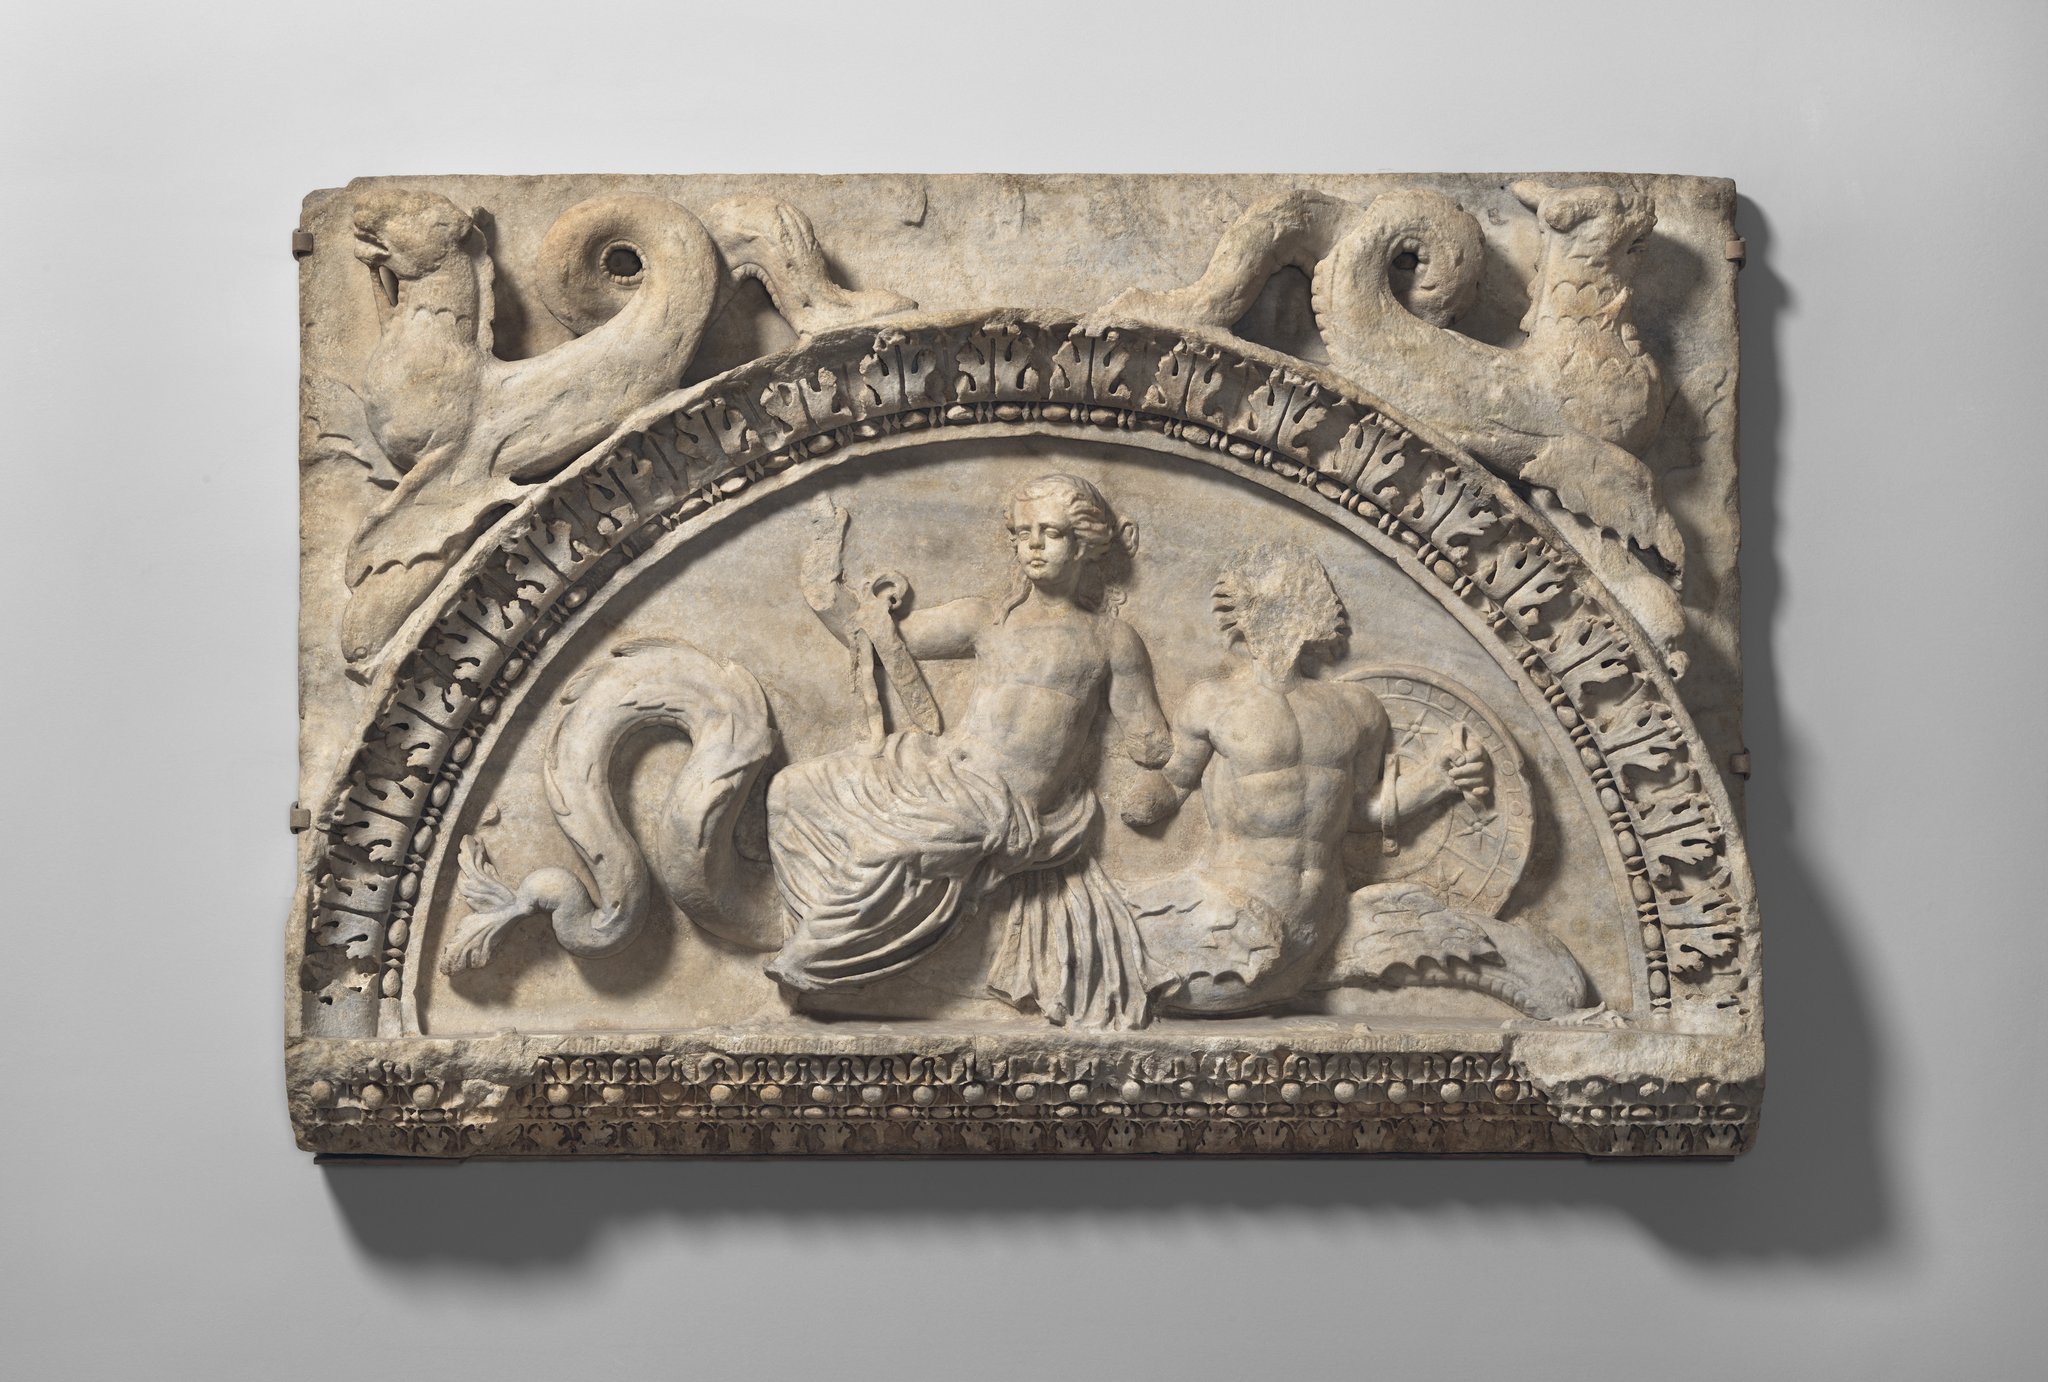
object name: relief with lunette showing nereid riding on a triton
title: Marble lunette with Nereid riding Triton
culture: roman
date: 101-125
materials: marble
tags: triton